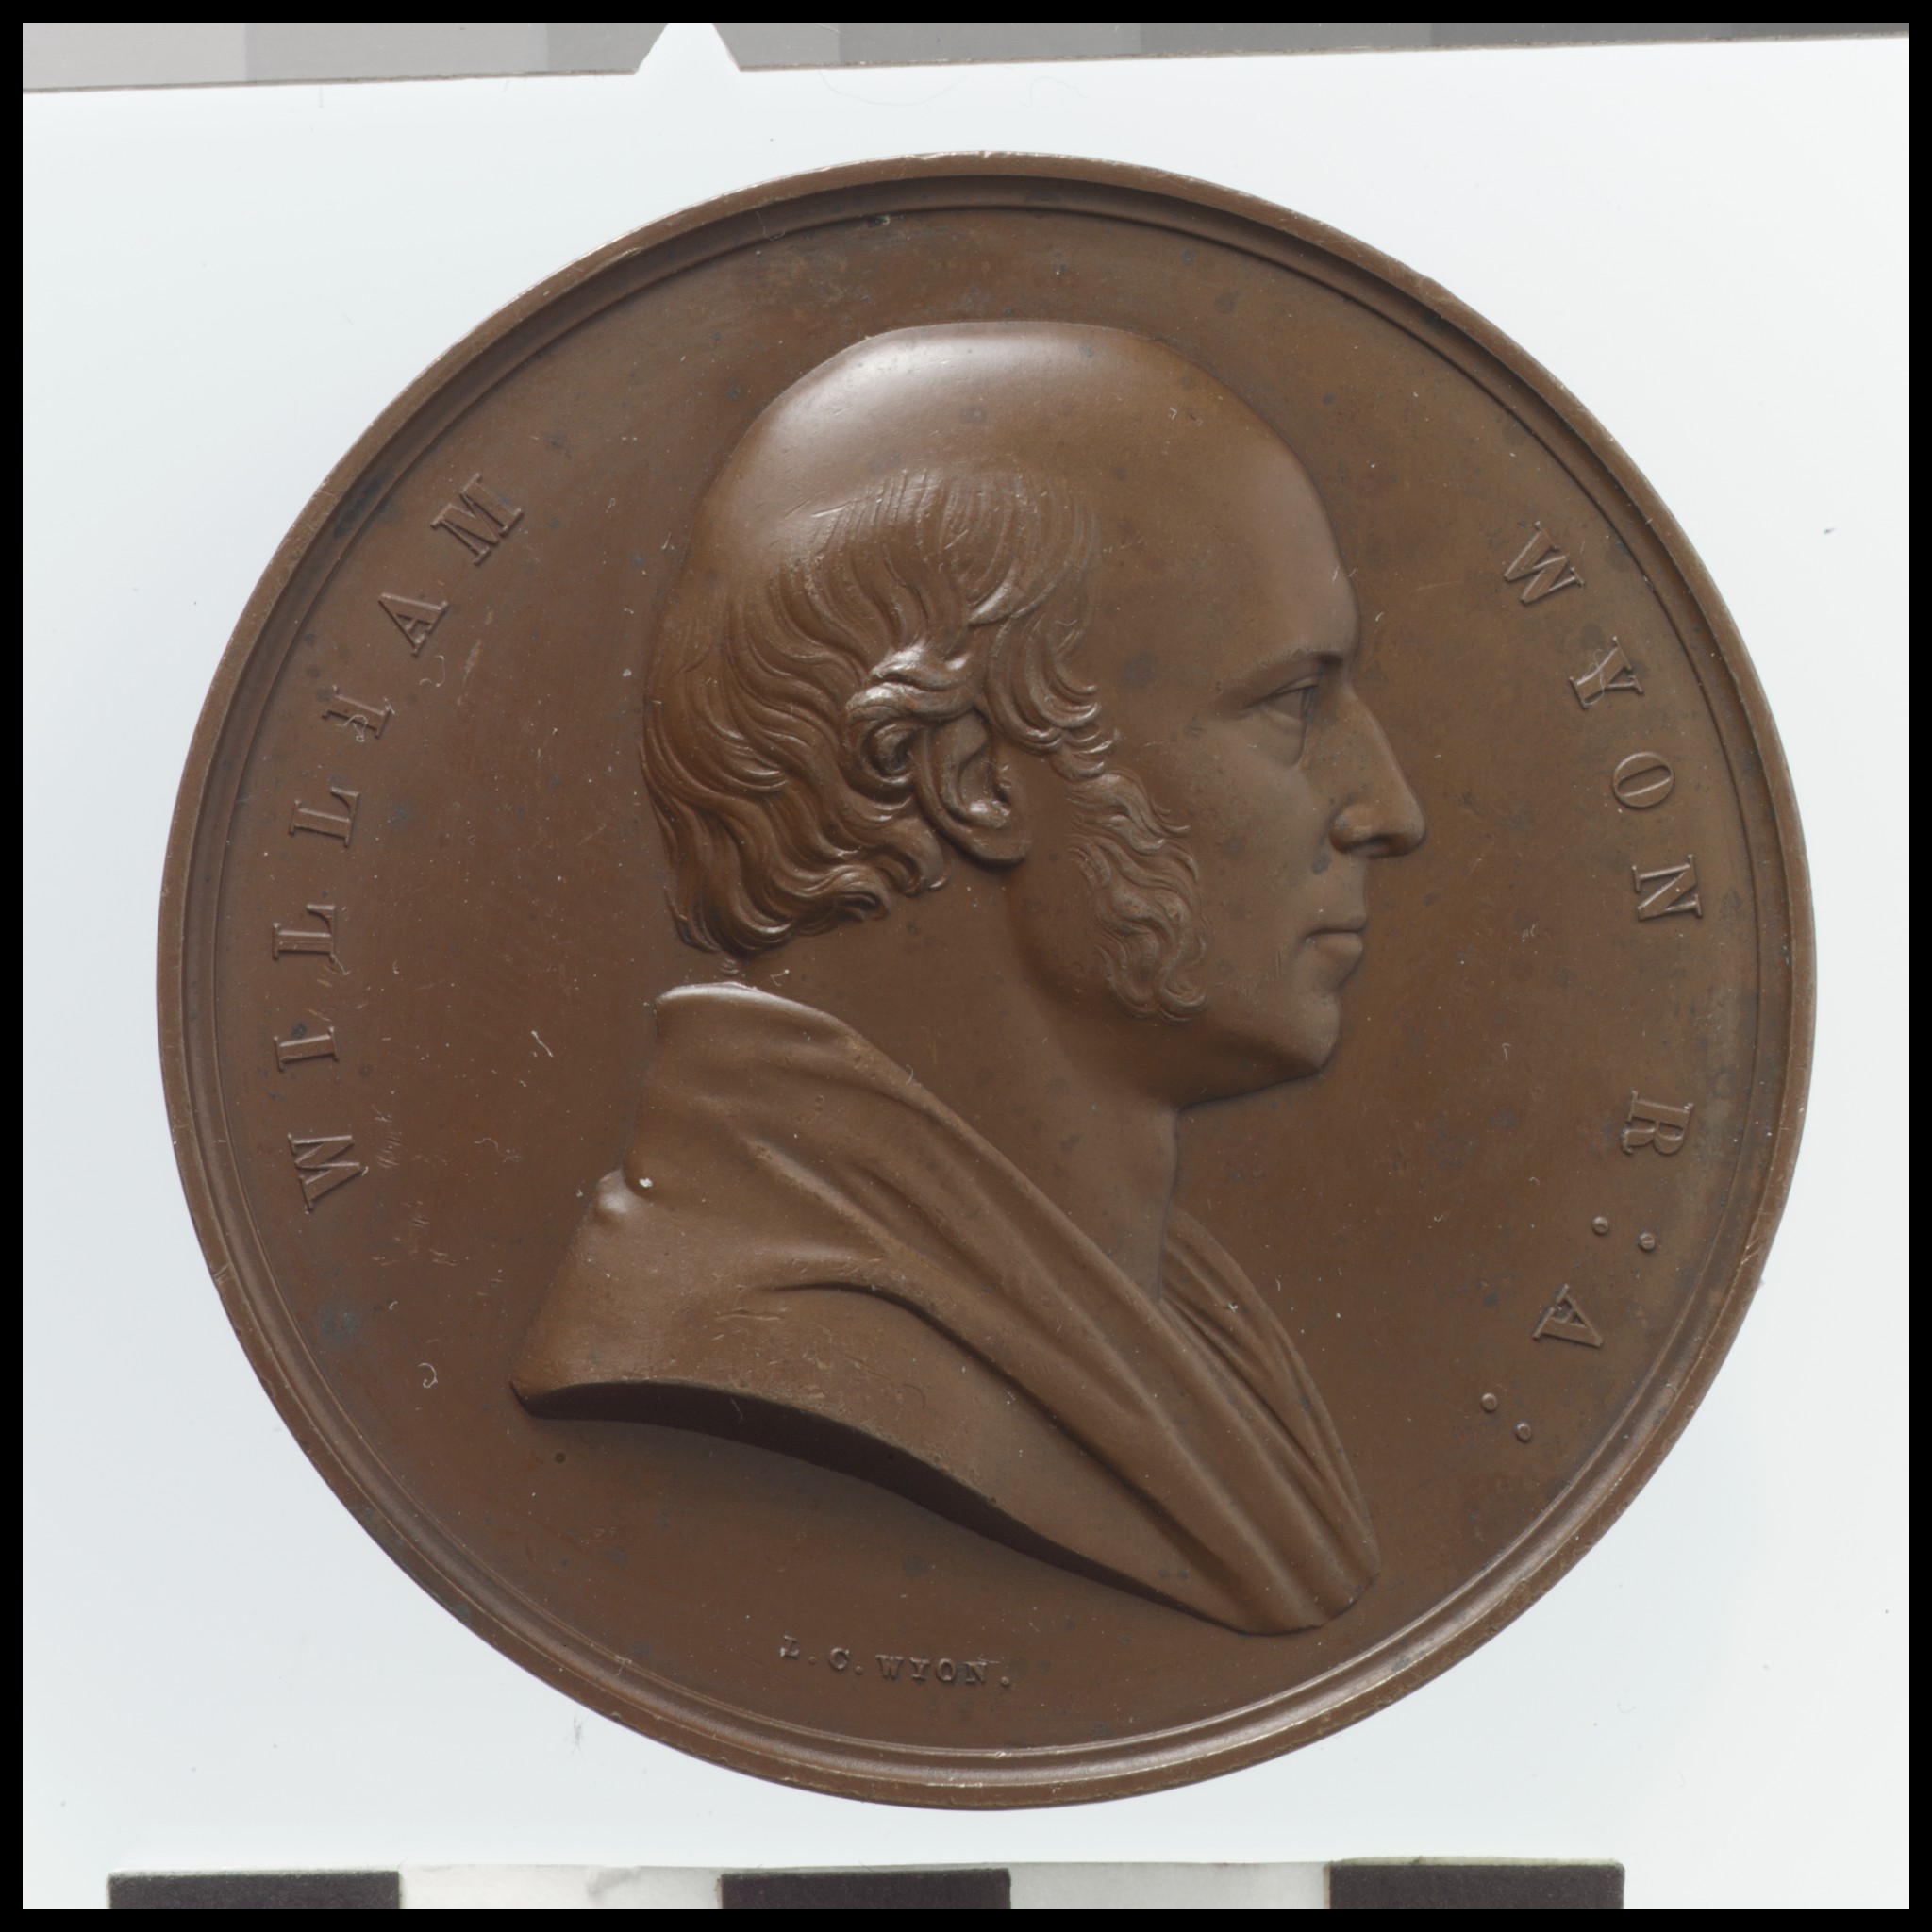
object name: medal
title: William Wyon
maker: leonard charles wyon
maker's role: maker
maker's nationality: british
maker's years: 1826-1891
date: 1854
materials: bronze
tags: men,profiles,women,horses